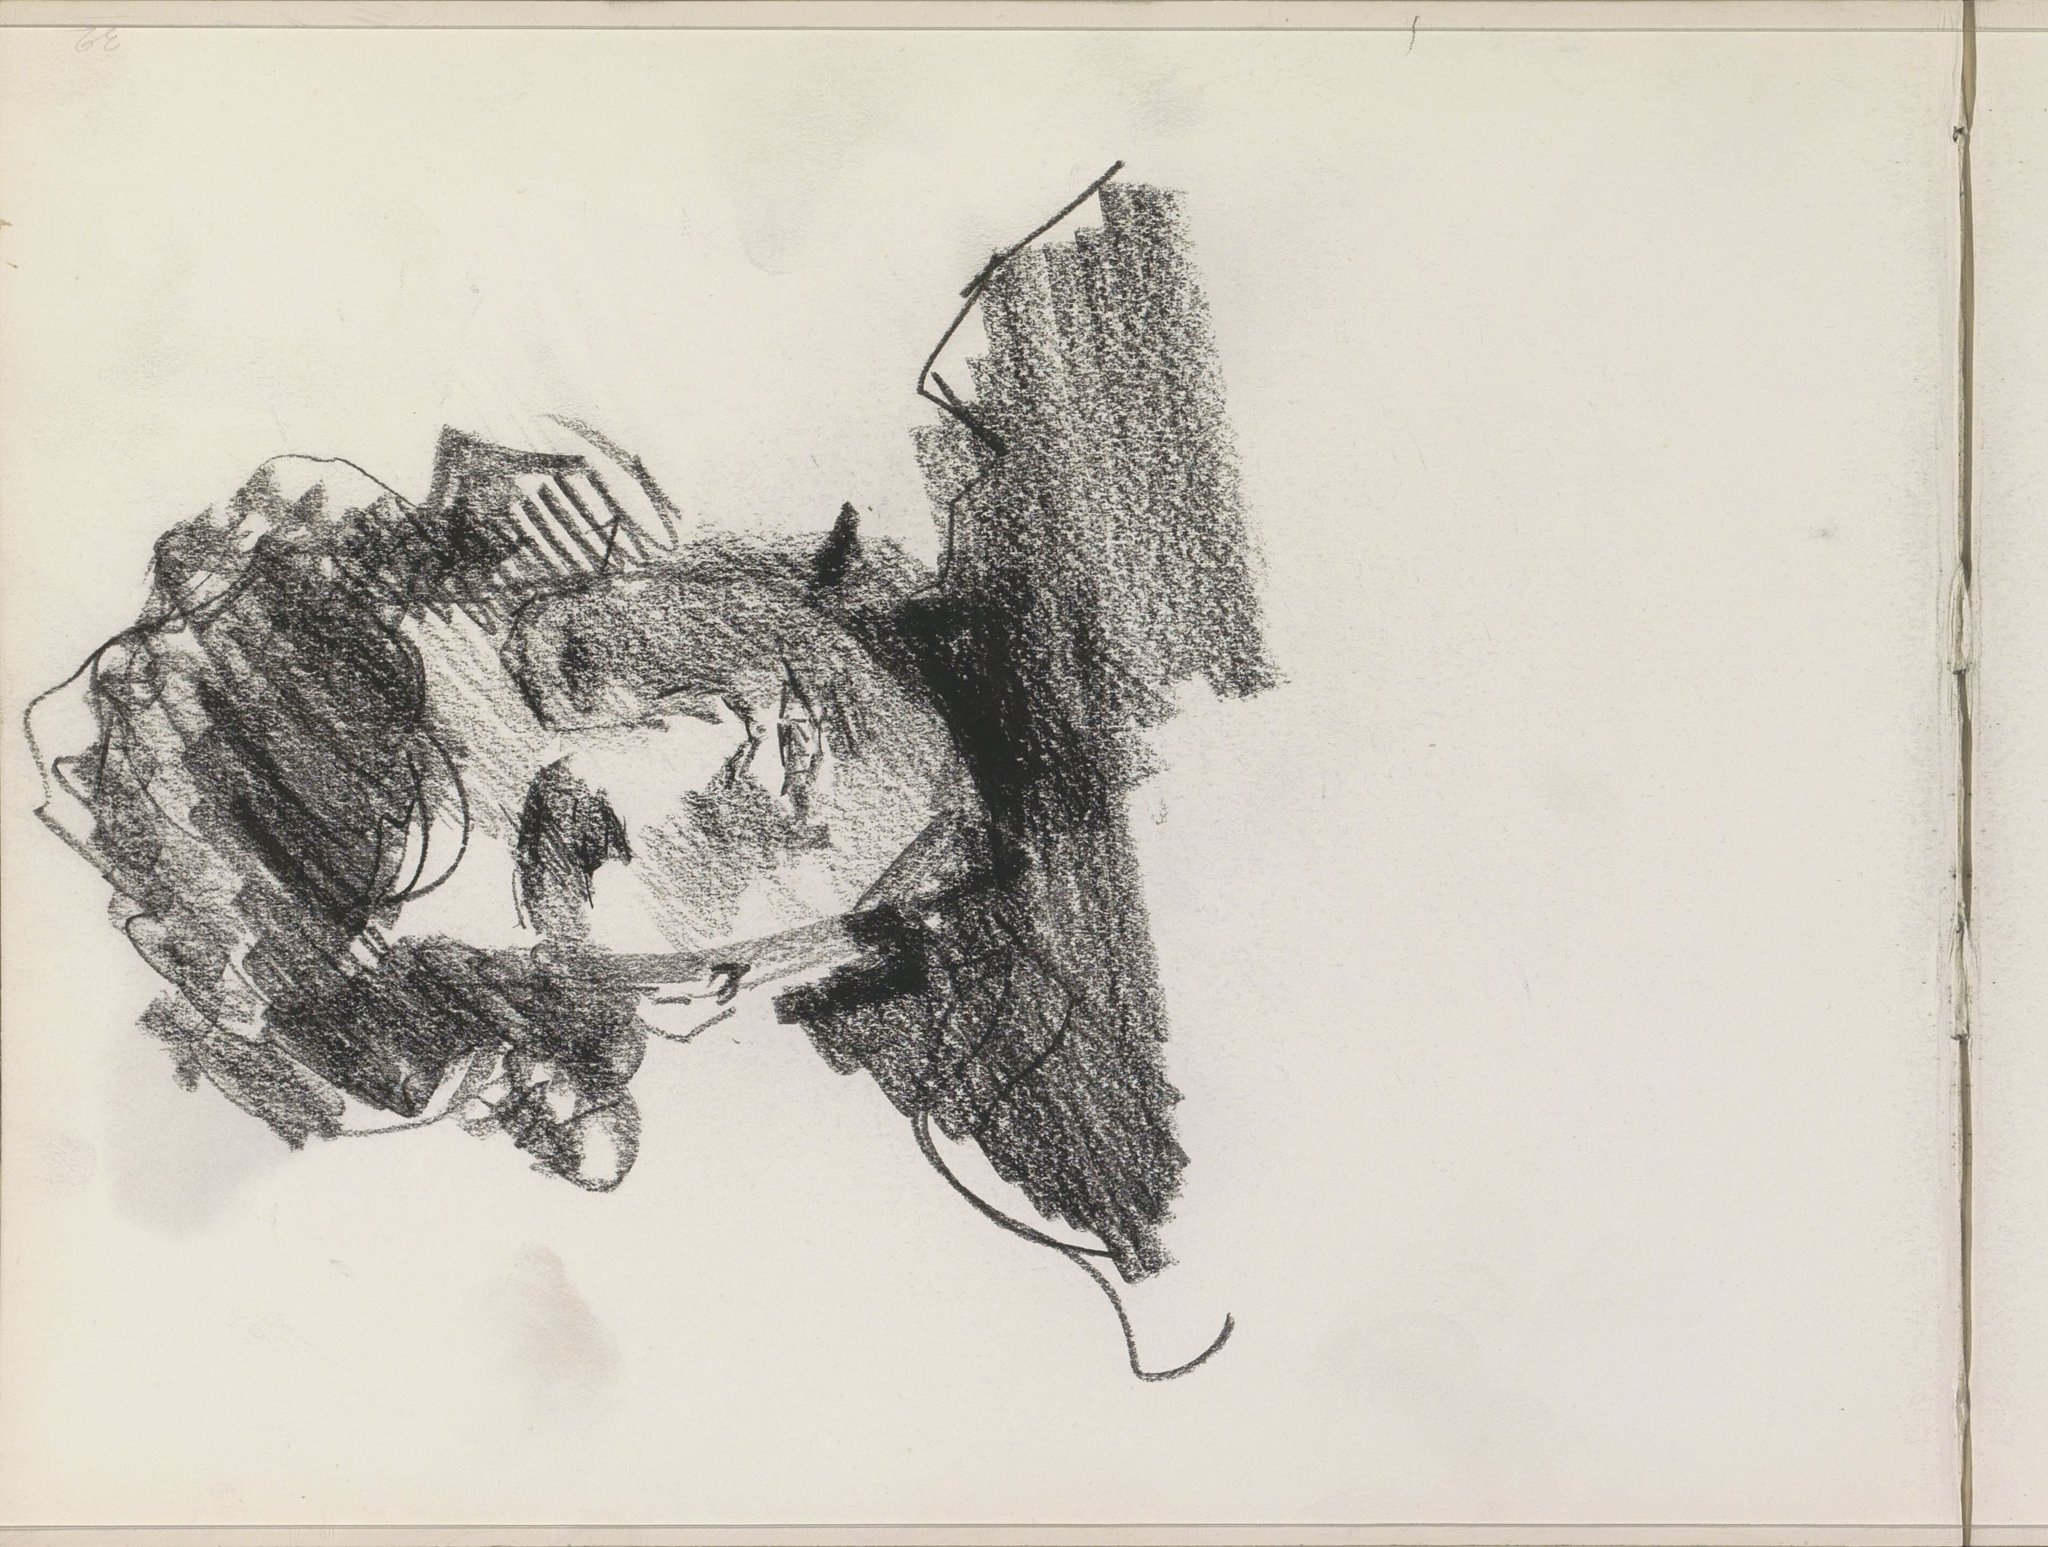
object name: sketchbook leaf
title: Vrouwenhoofd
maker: isaac israels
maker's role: draughtsman, painter, print maker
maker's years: 1865-1934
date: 1875-1934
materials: chalk, paper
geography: the hague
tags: head (human) - aa - female human figure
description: Blad 21 verso uit schetsboek VII met 26 bladen.